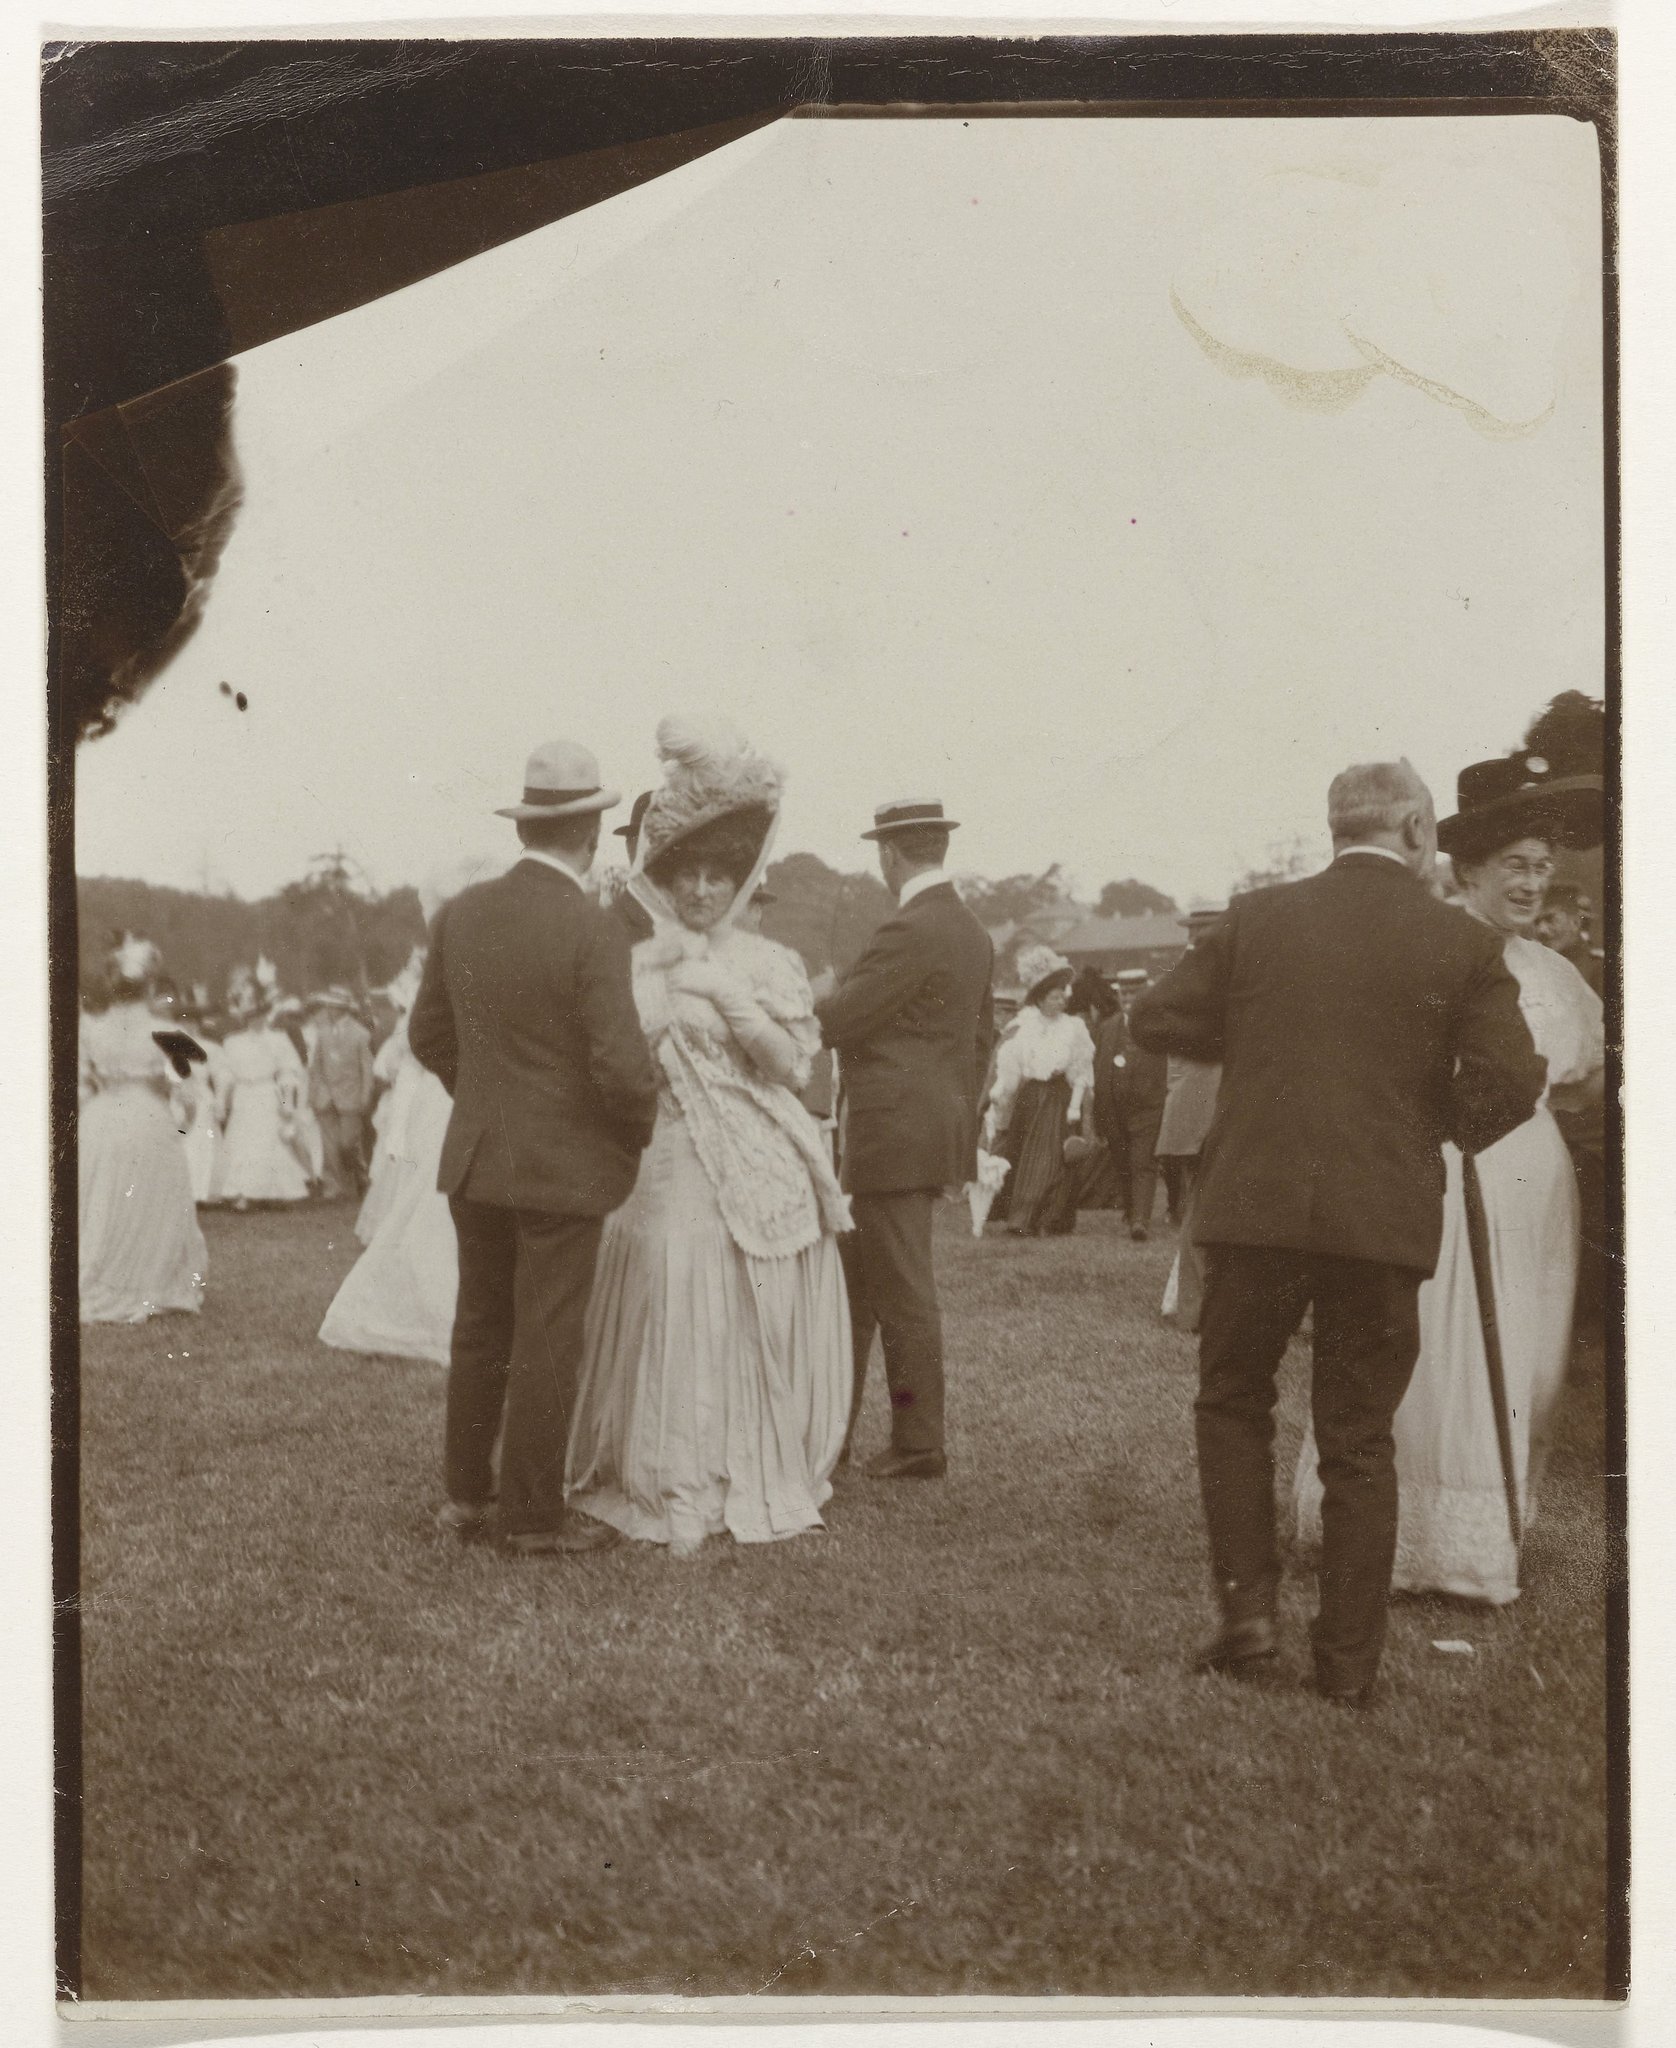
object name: photograph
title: Bezoekers van een paardenrenbaan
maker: Anonymous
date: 1900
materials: paper, photographic support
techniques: gelatin silver print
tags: horse-racing